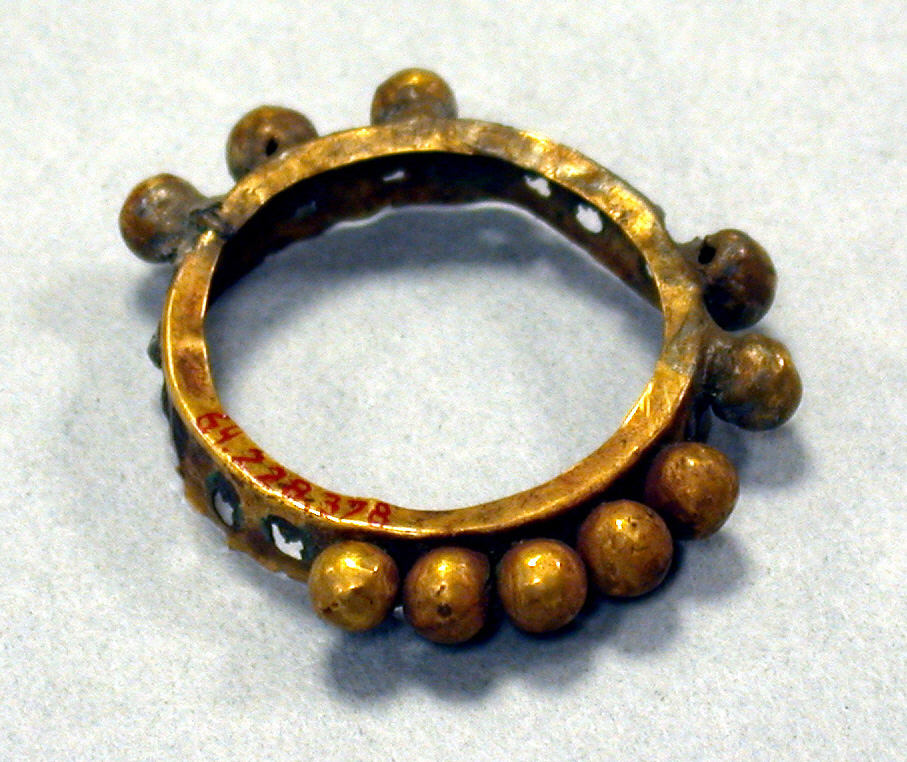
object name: ornament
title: Hammered Gold Band with Bells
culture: peruvian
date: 1-1566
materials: gold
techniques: hammering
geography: peru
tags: musical instruments